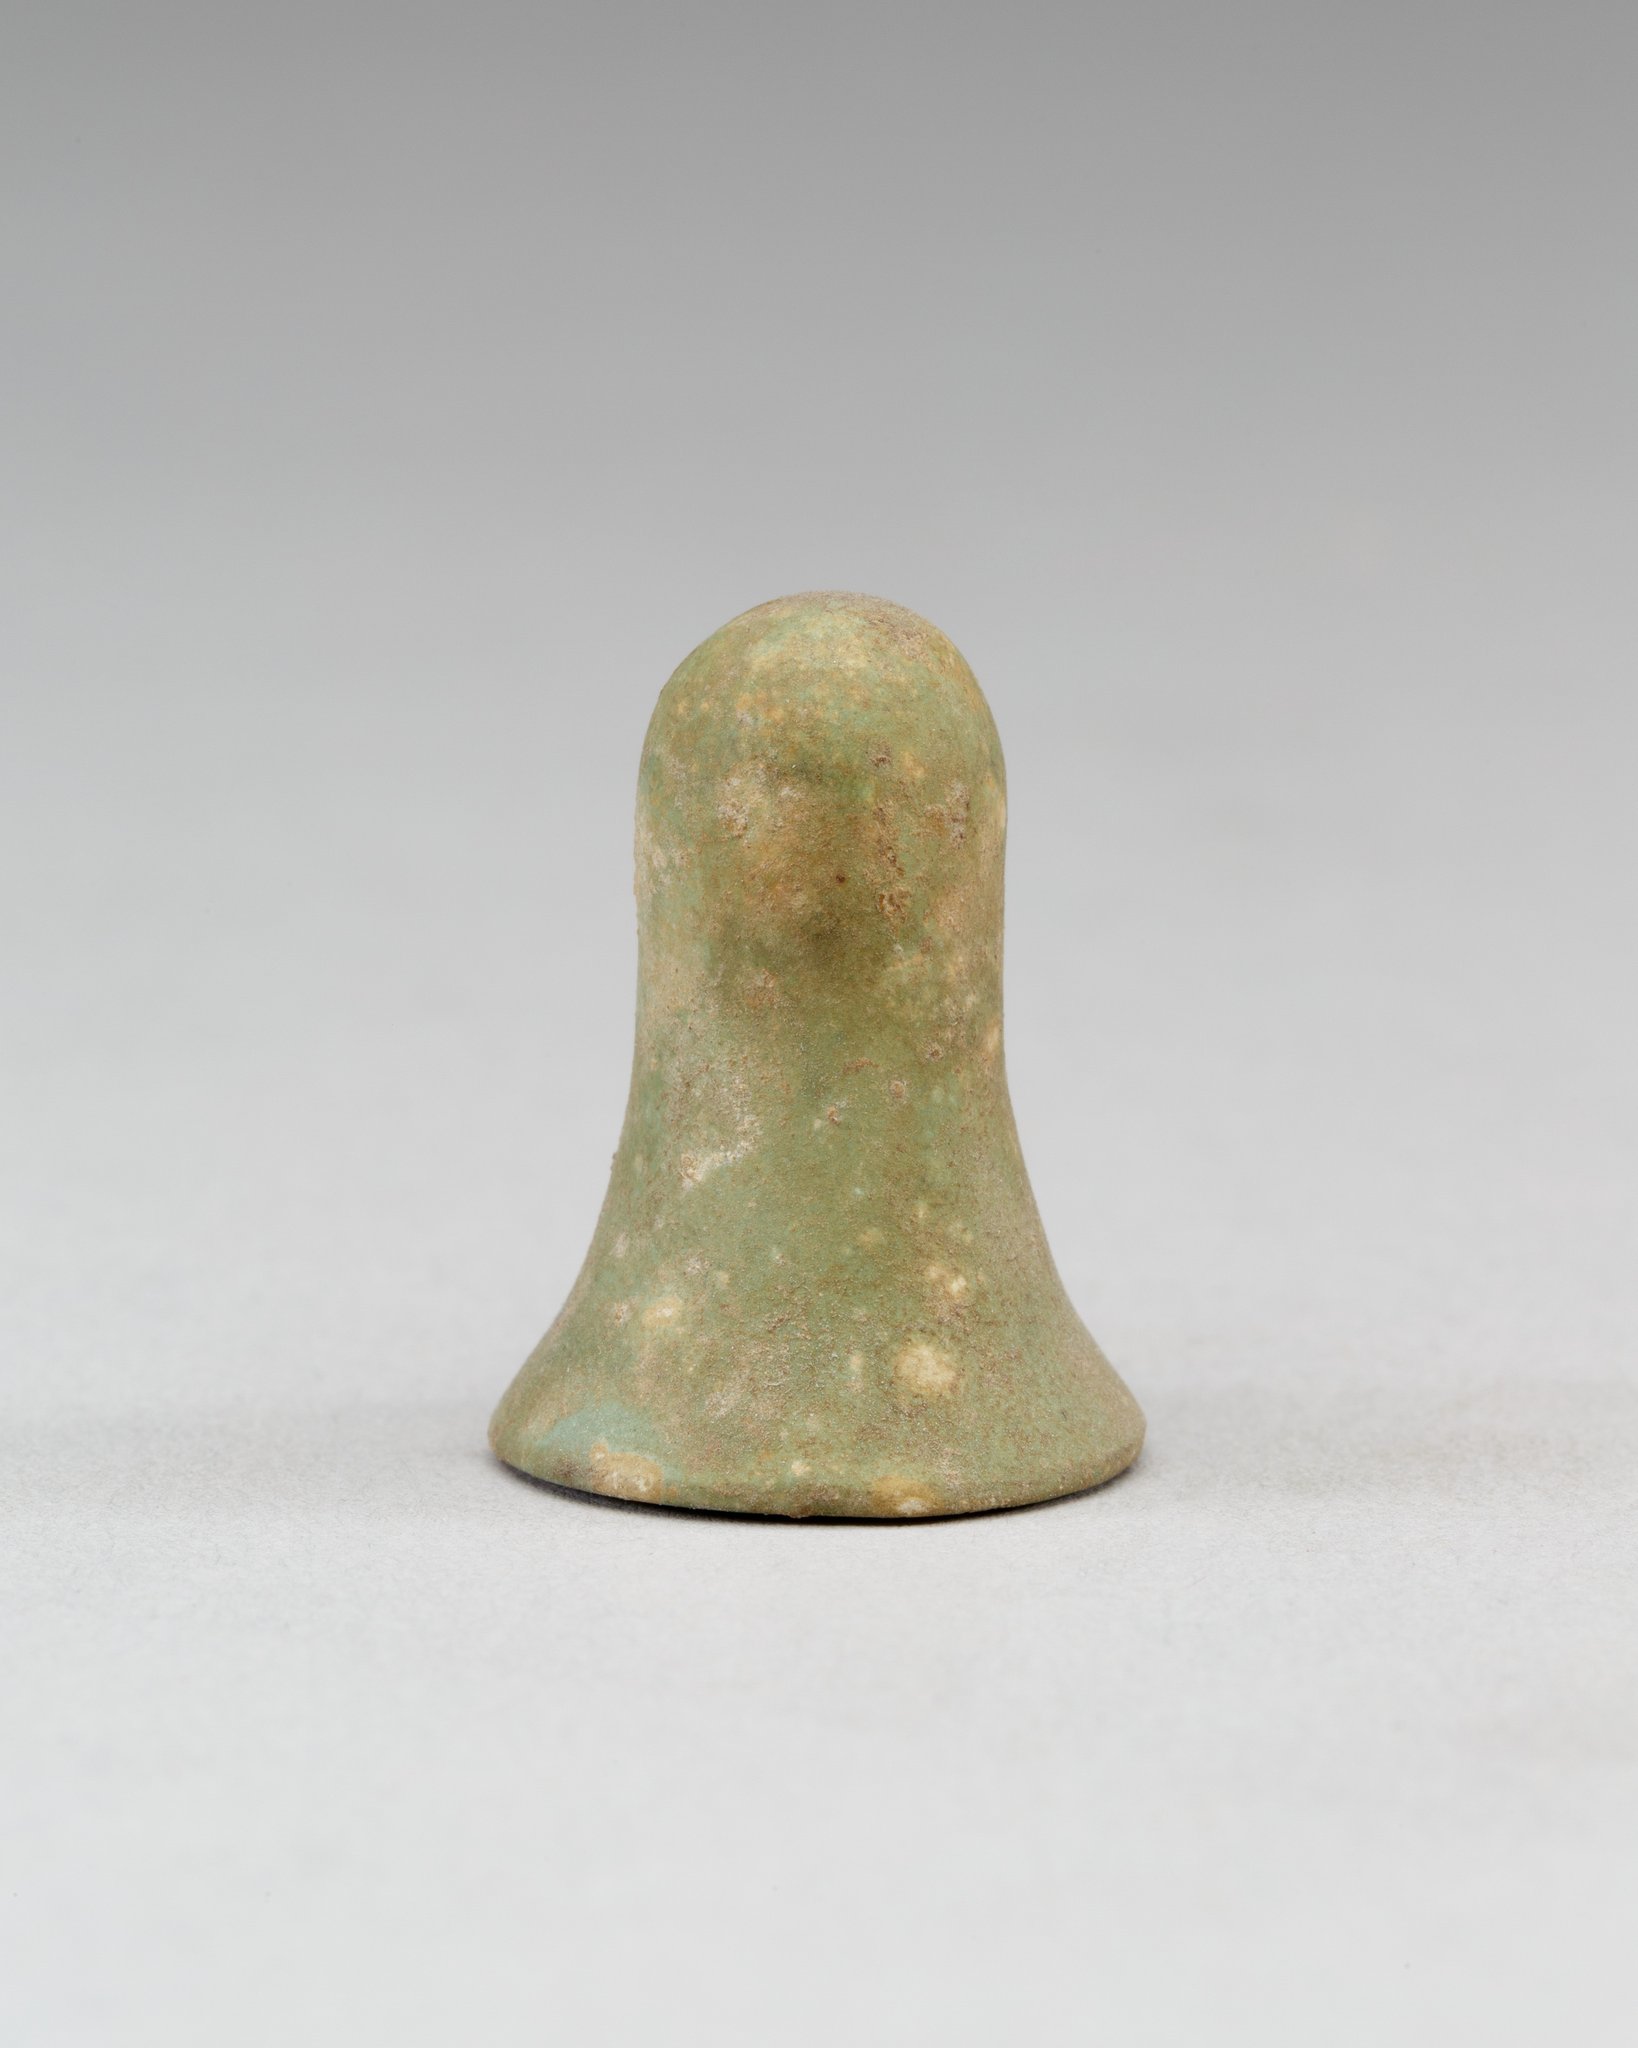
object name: game piece, conical, burial 8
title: Conical Gaming Piece from Neferkhawet's Tomb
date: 1504-1447 BCE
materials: faience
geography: egypt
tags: games